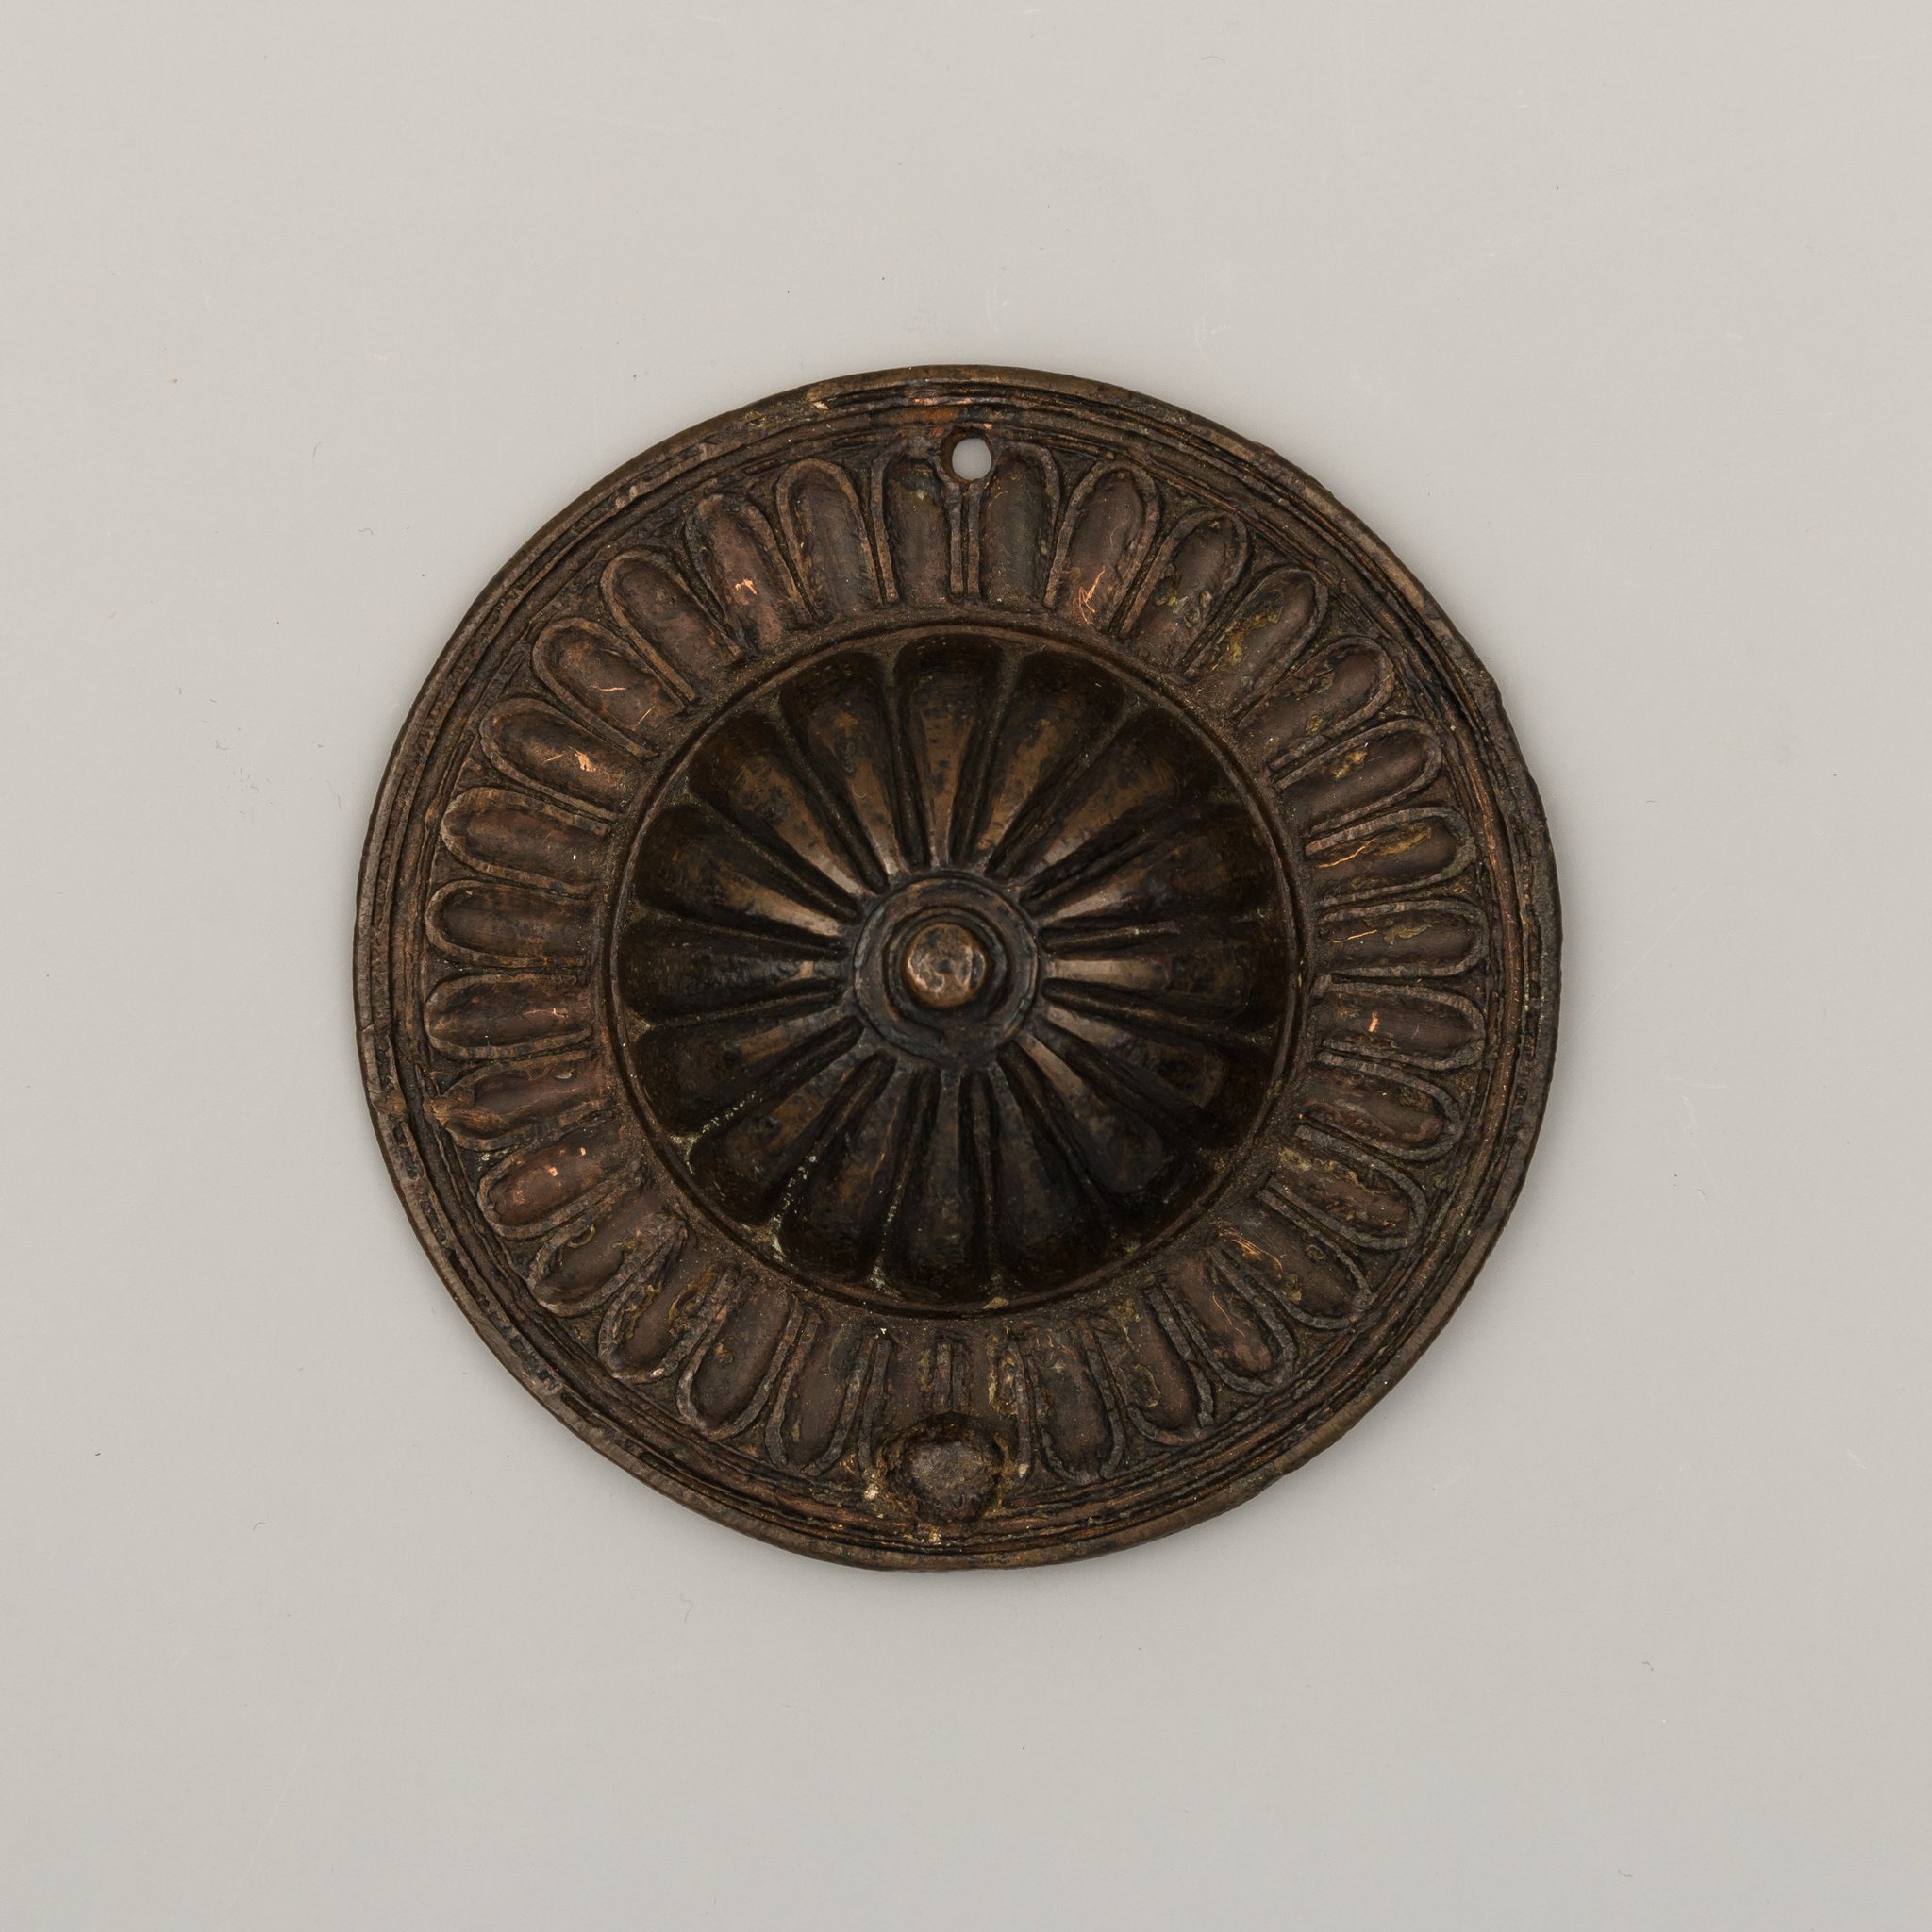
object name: bit bos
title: Bit Boss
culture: french or italian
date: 1501-1633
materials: copper alloy, iron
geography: france